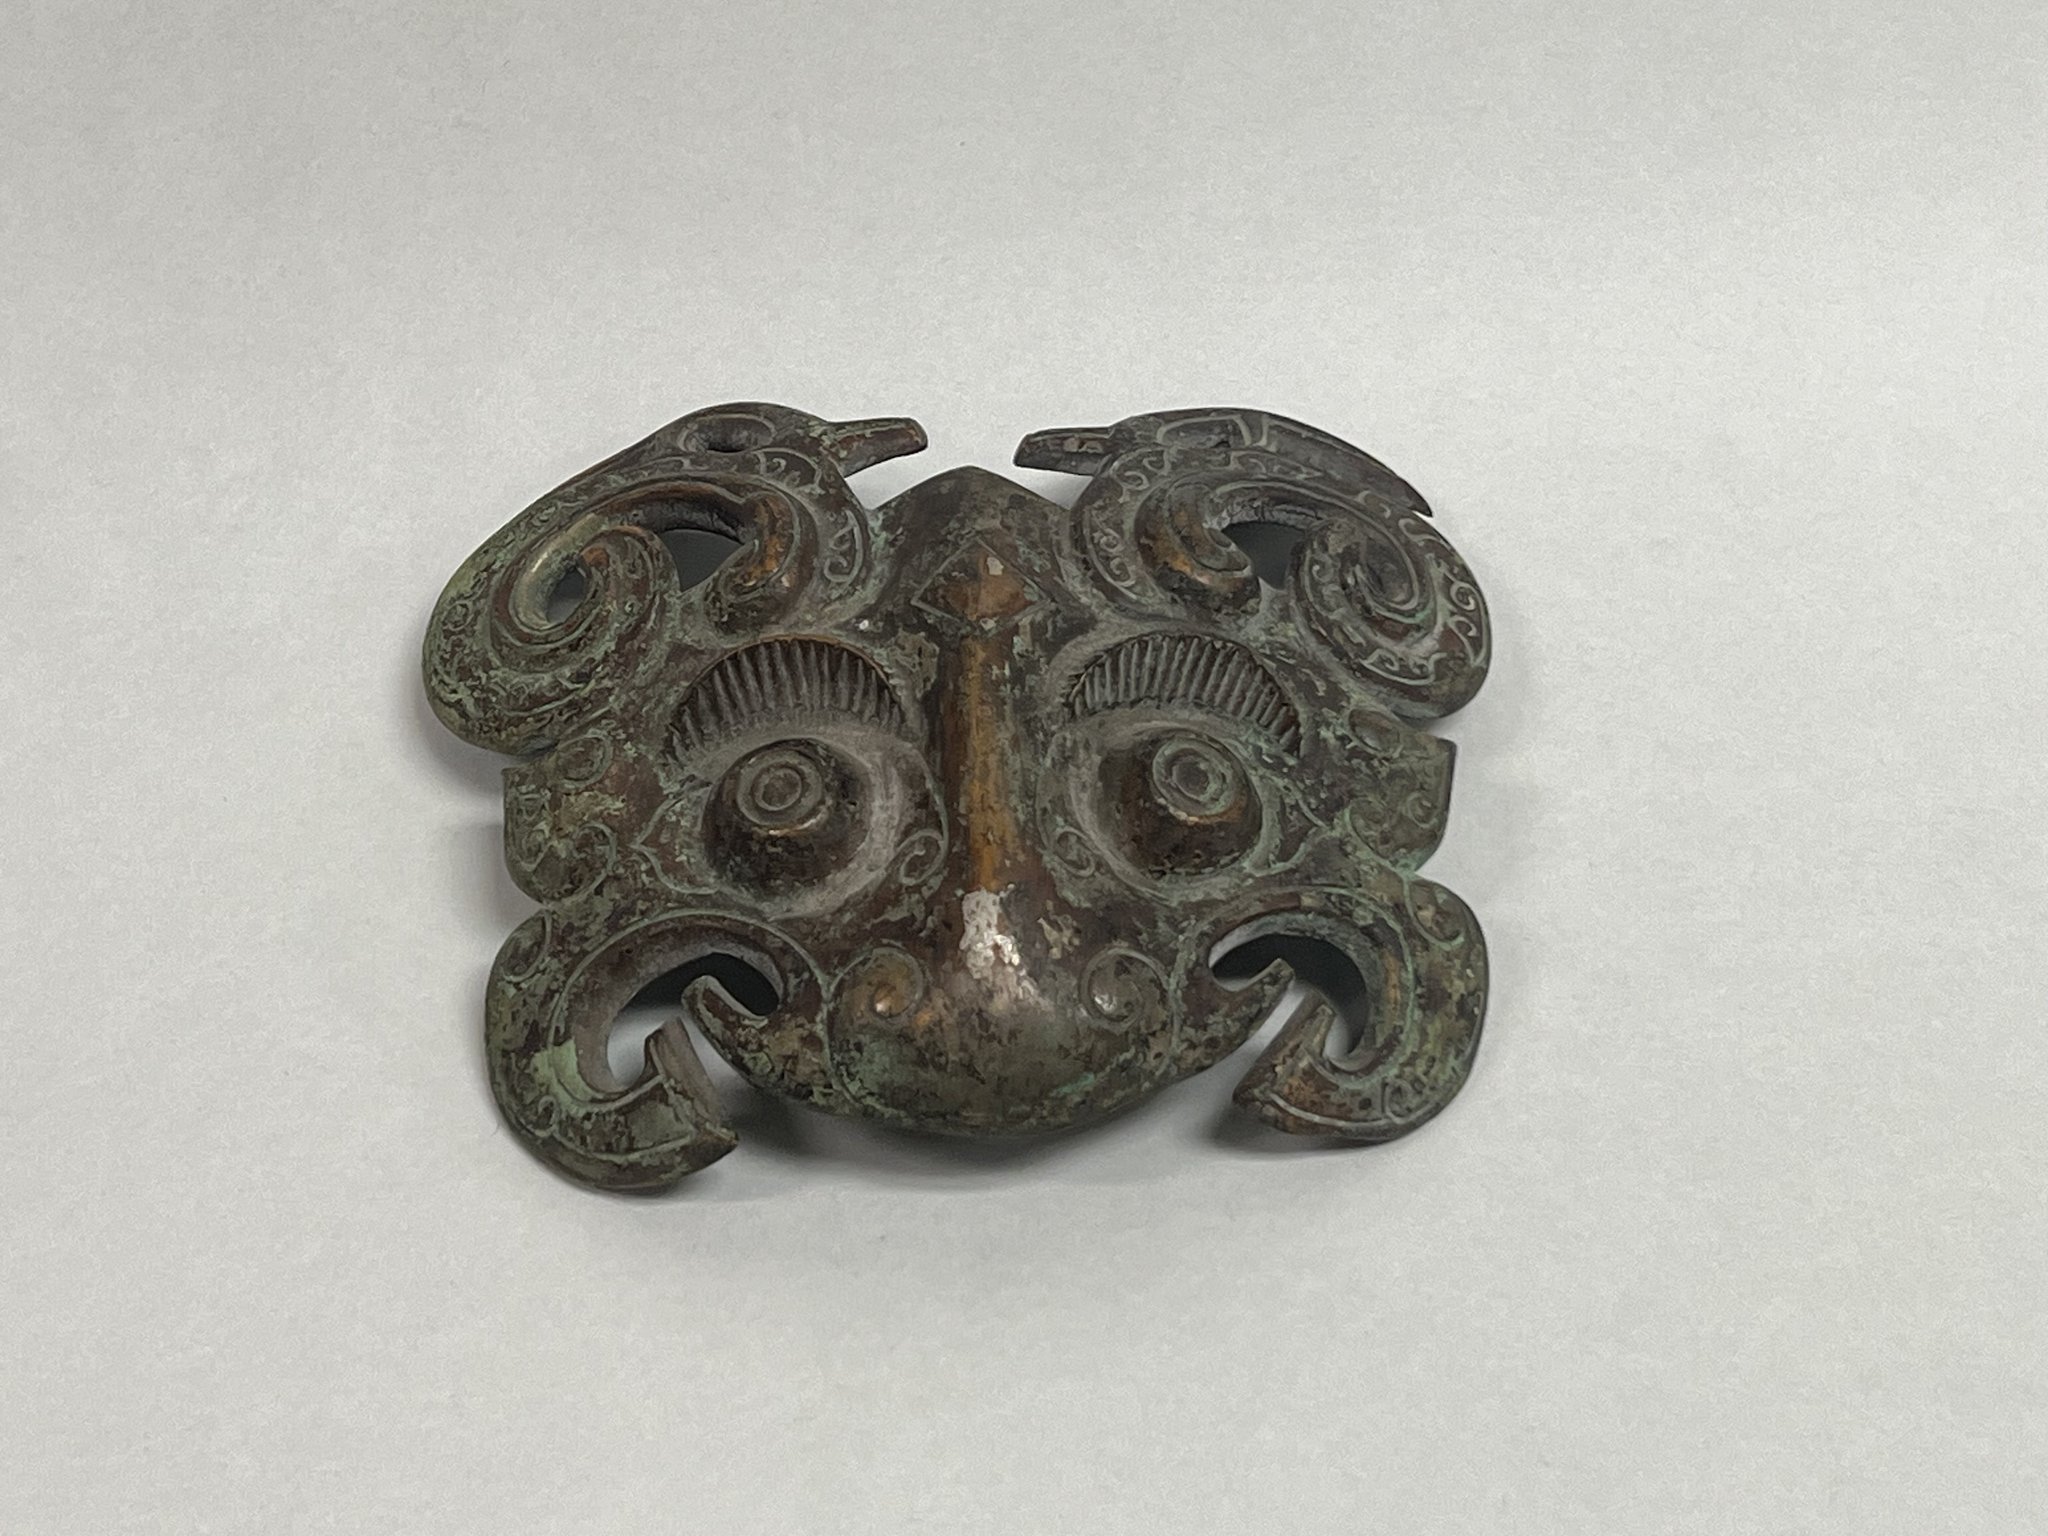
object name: mask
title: Animal Mask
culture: chinese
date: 934-768 BCE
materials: copper, silver gilt